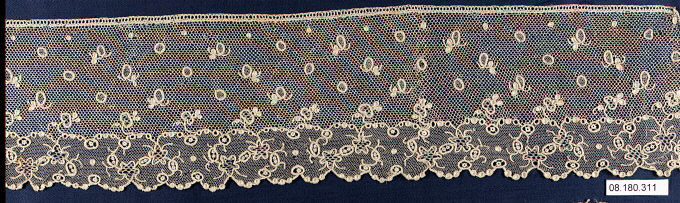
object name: fragment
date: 1801-1833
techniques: lace